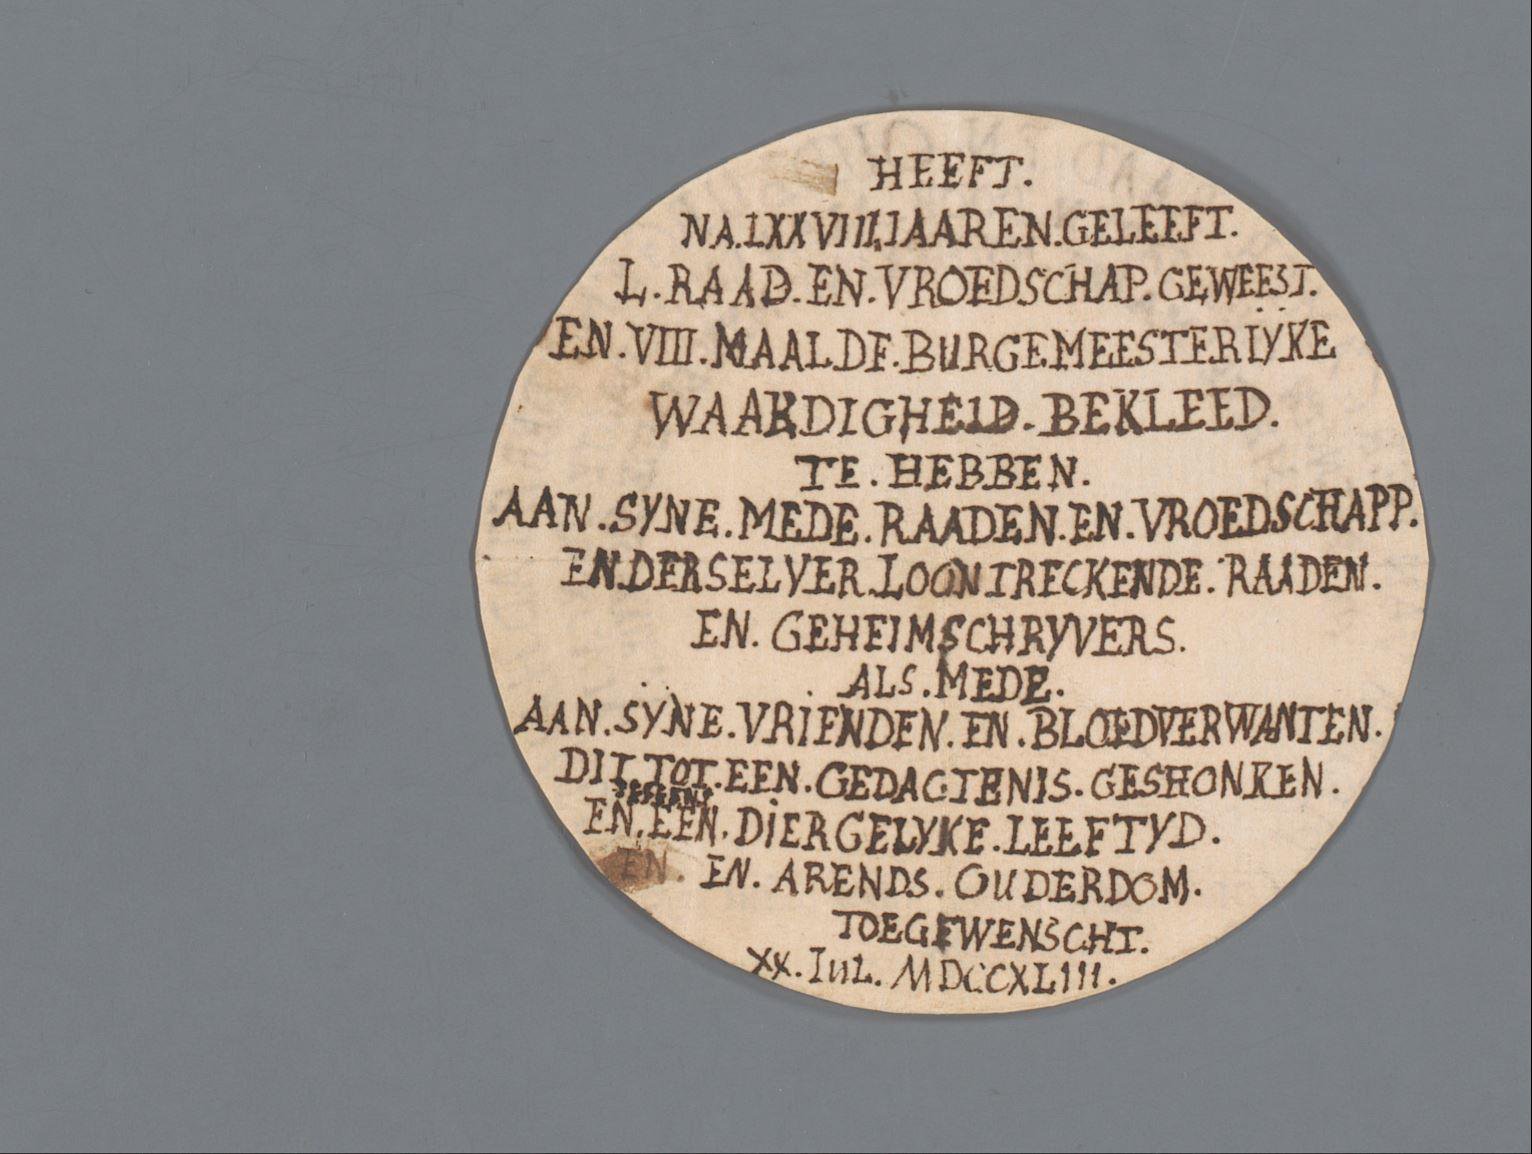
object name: design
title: Ontwerp voor een historiepenning voor raad, schepen en oud-burgemeester van Haarlem Pieter van der Camer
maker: Anonymous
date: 1743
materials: ink, paper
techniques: pen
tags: pieter van der camer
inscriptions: date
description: De uiteindelijke penning werd vervaardigd door Martin Holtzhey (zie documentatie).